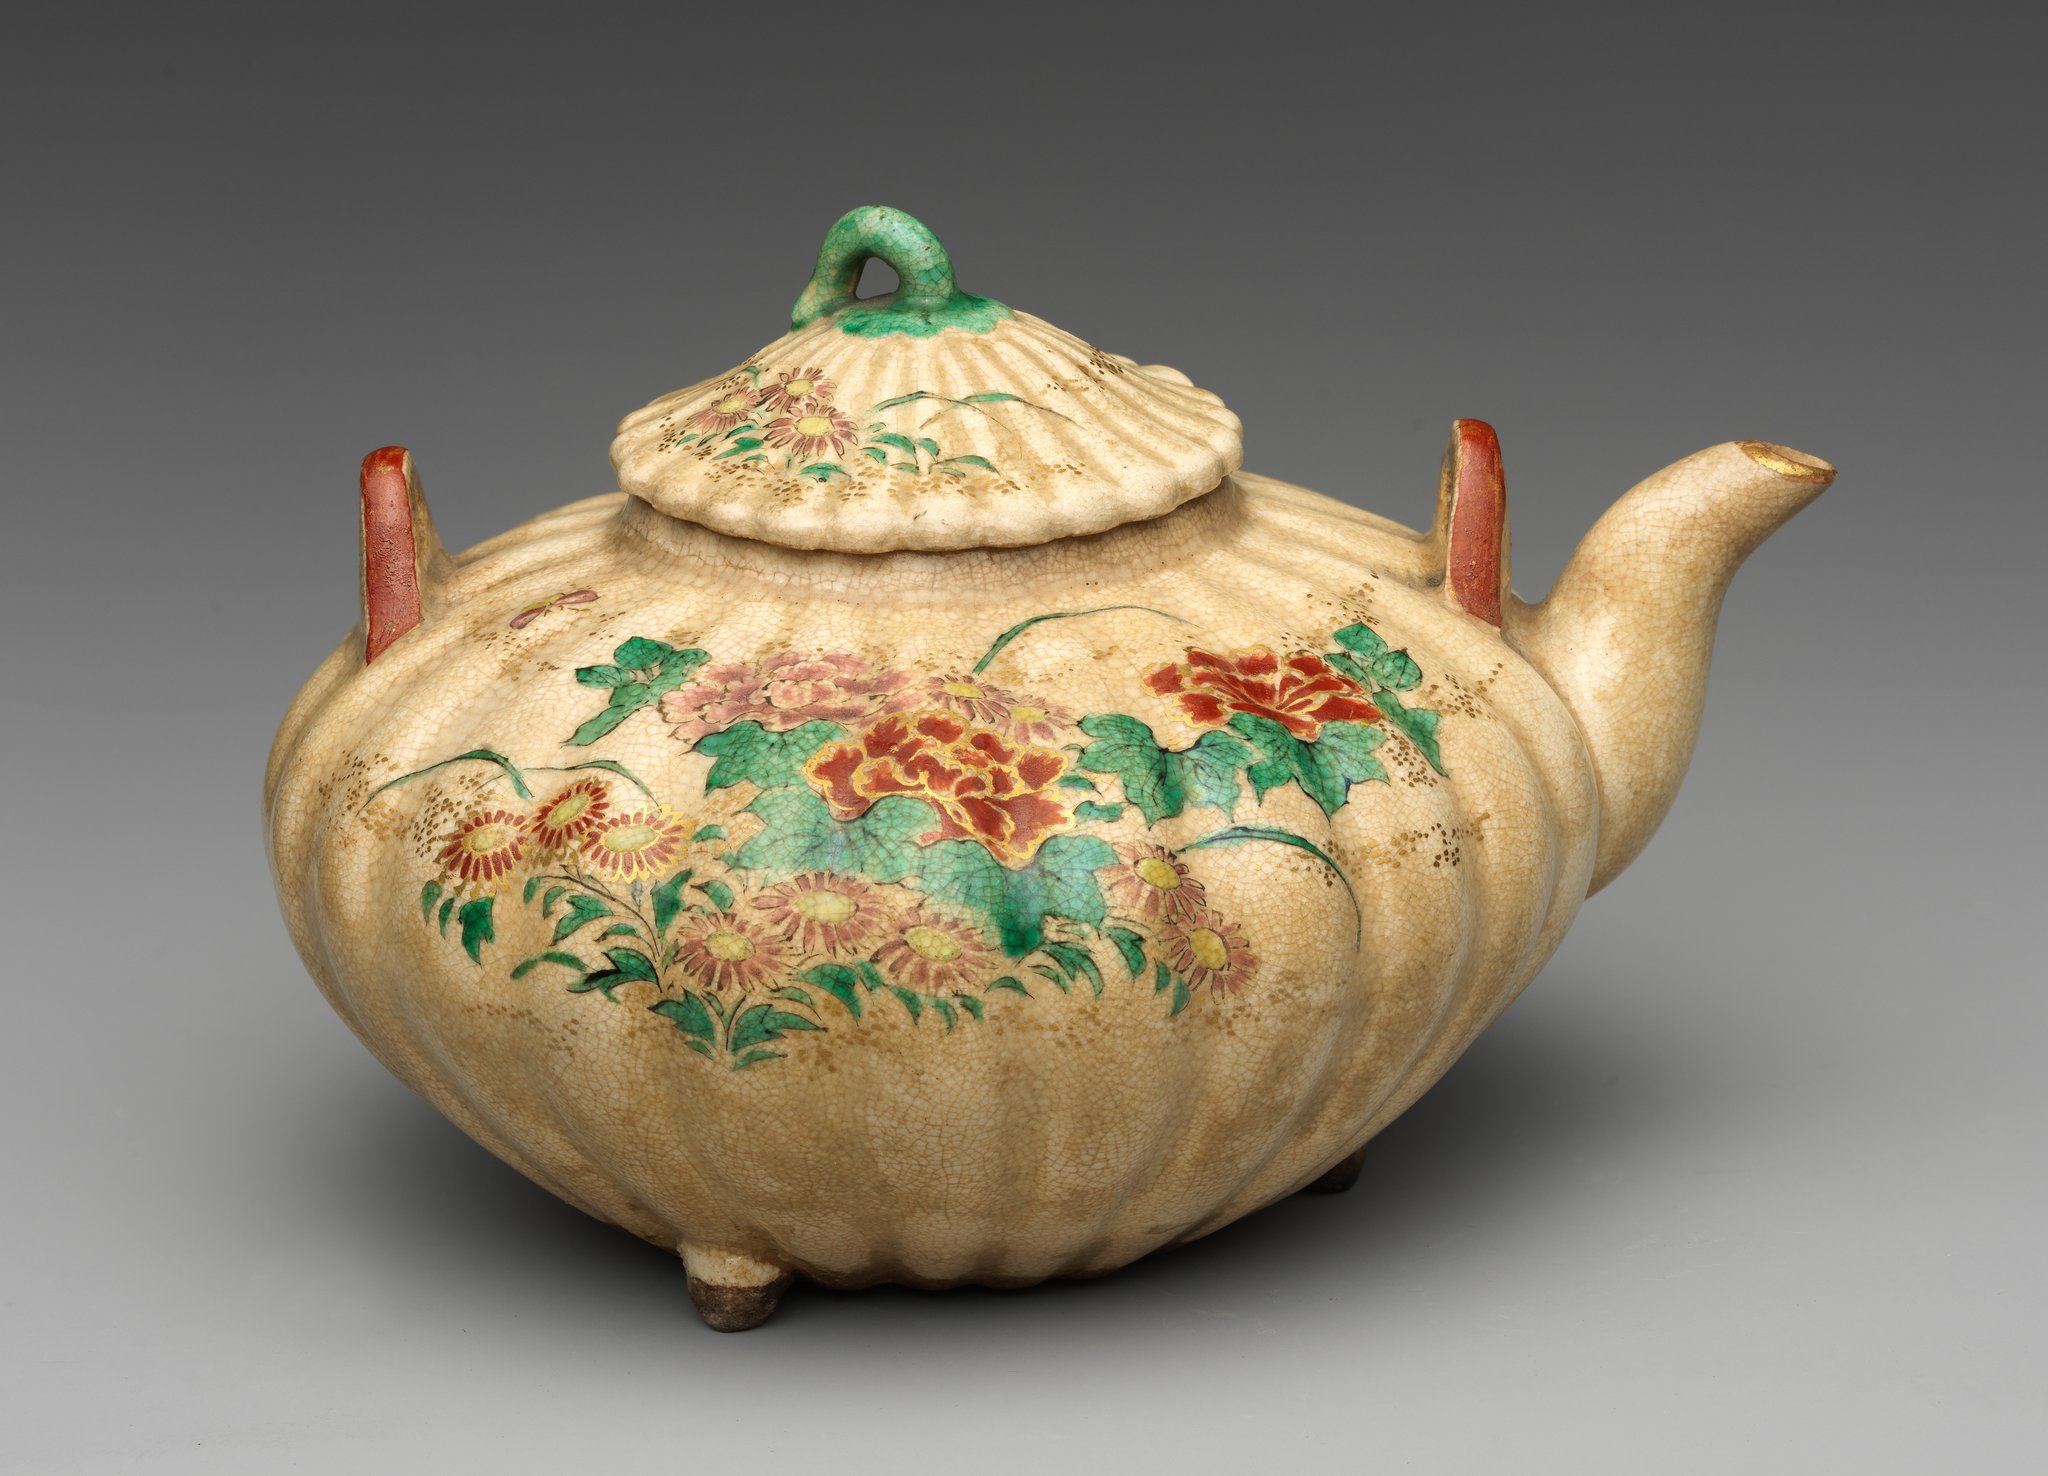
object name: teapot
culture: japanese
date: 1865-1870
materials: glaze, pottery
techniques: enamel, gilding, overglaze